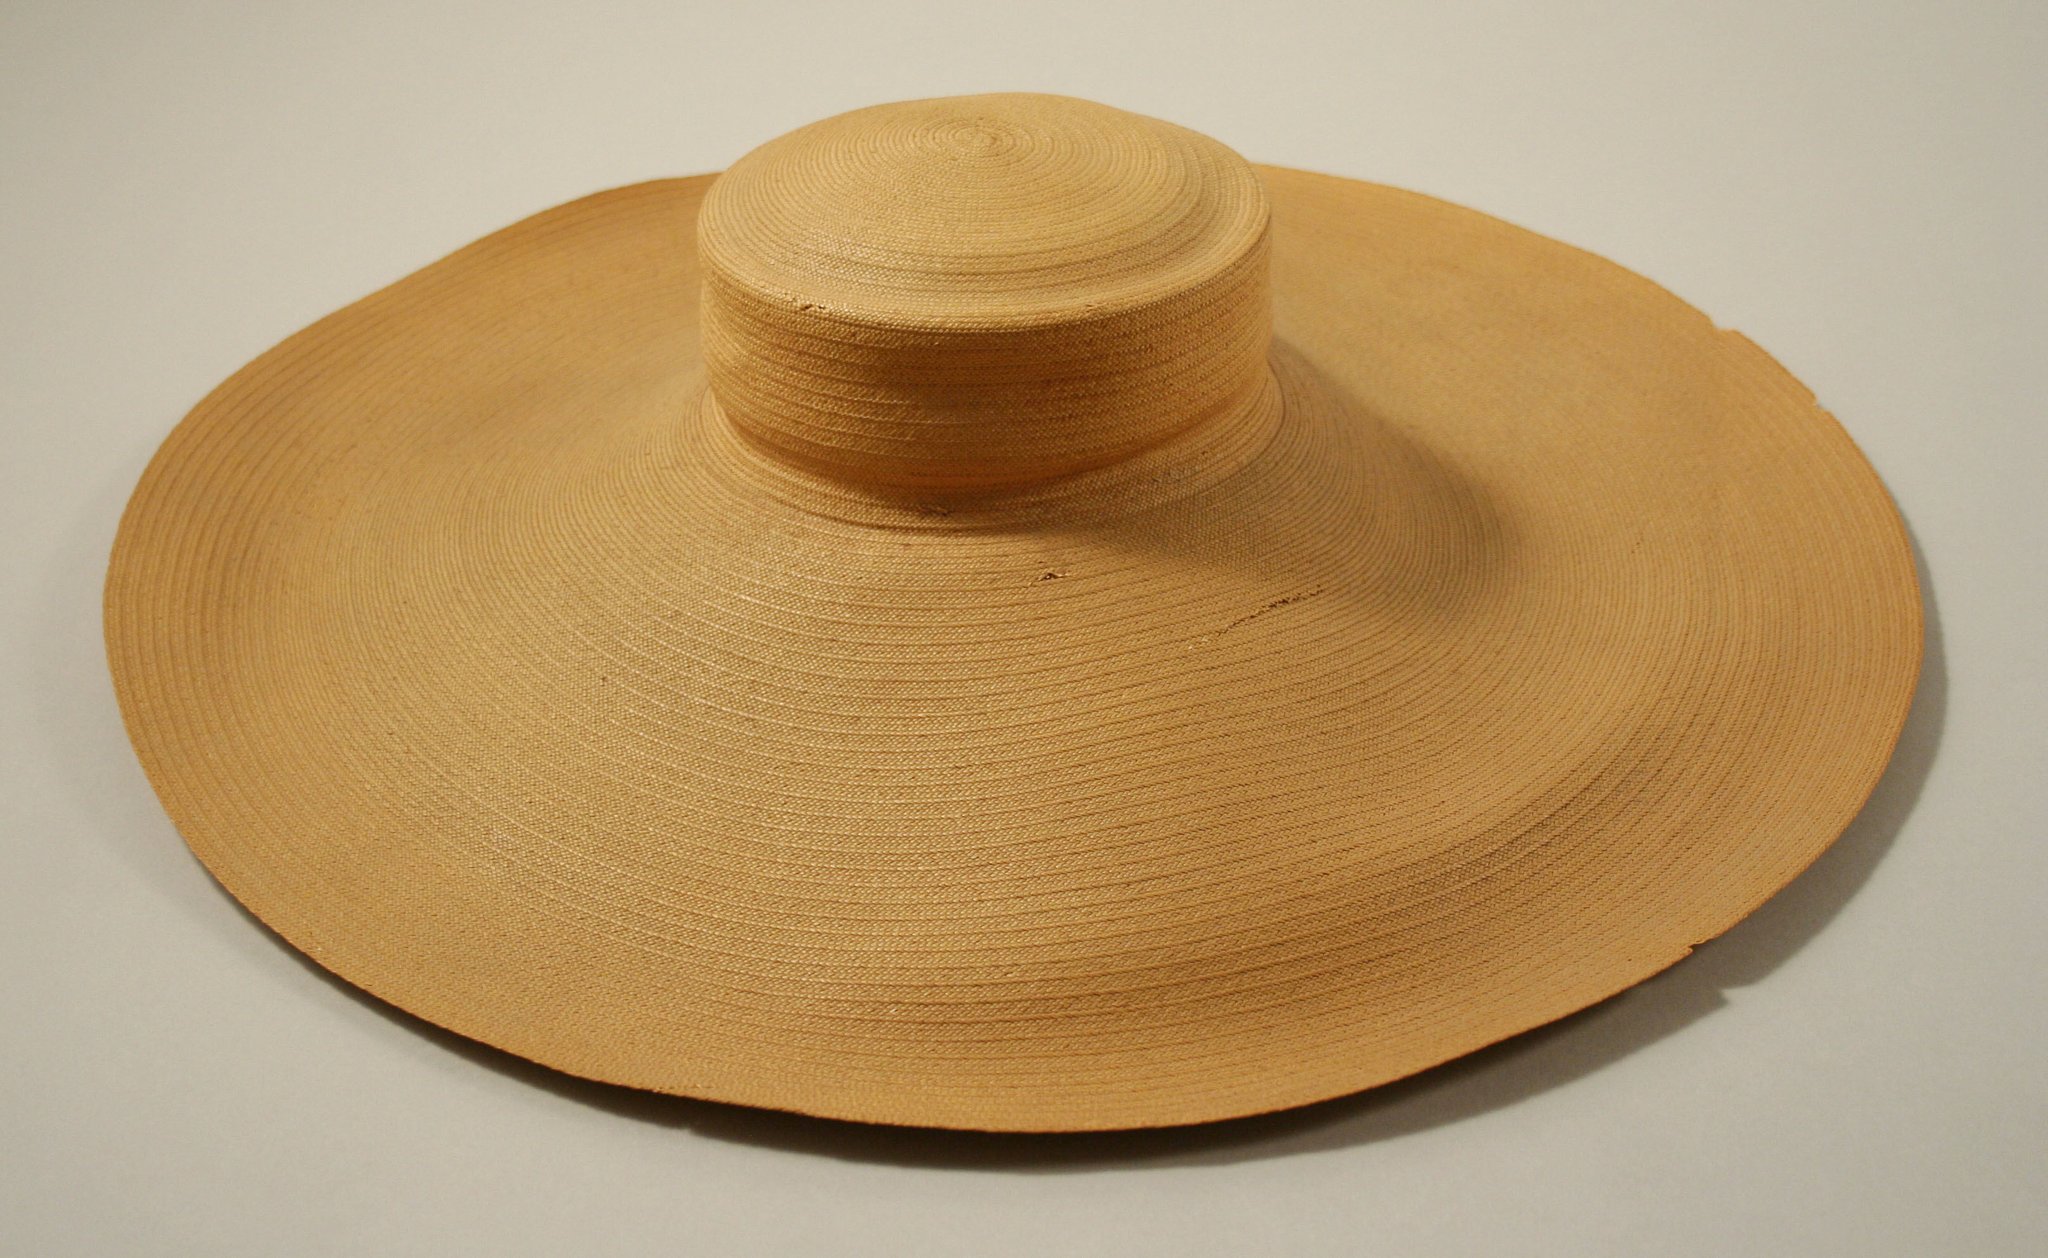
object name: hat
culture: american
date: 1850-1870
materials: fiber